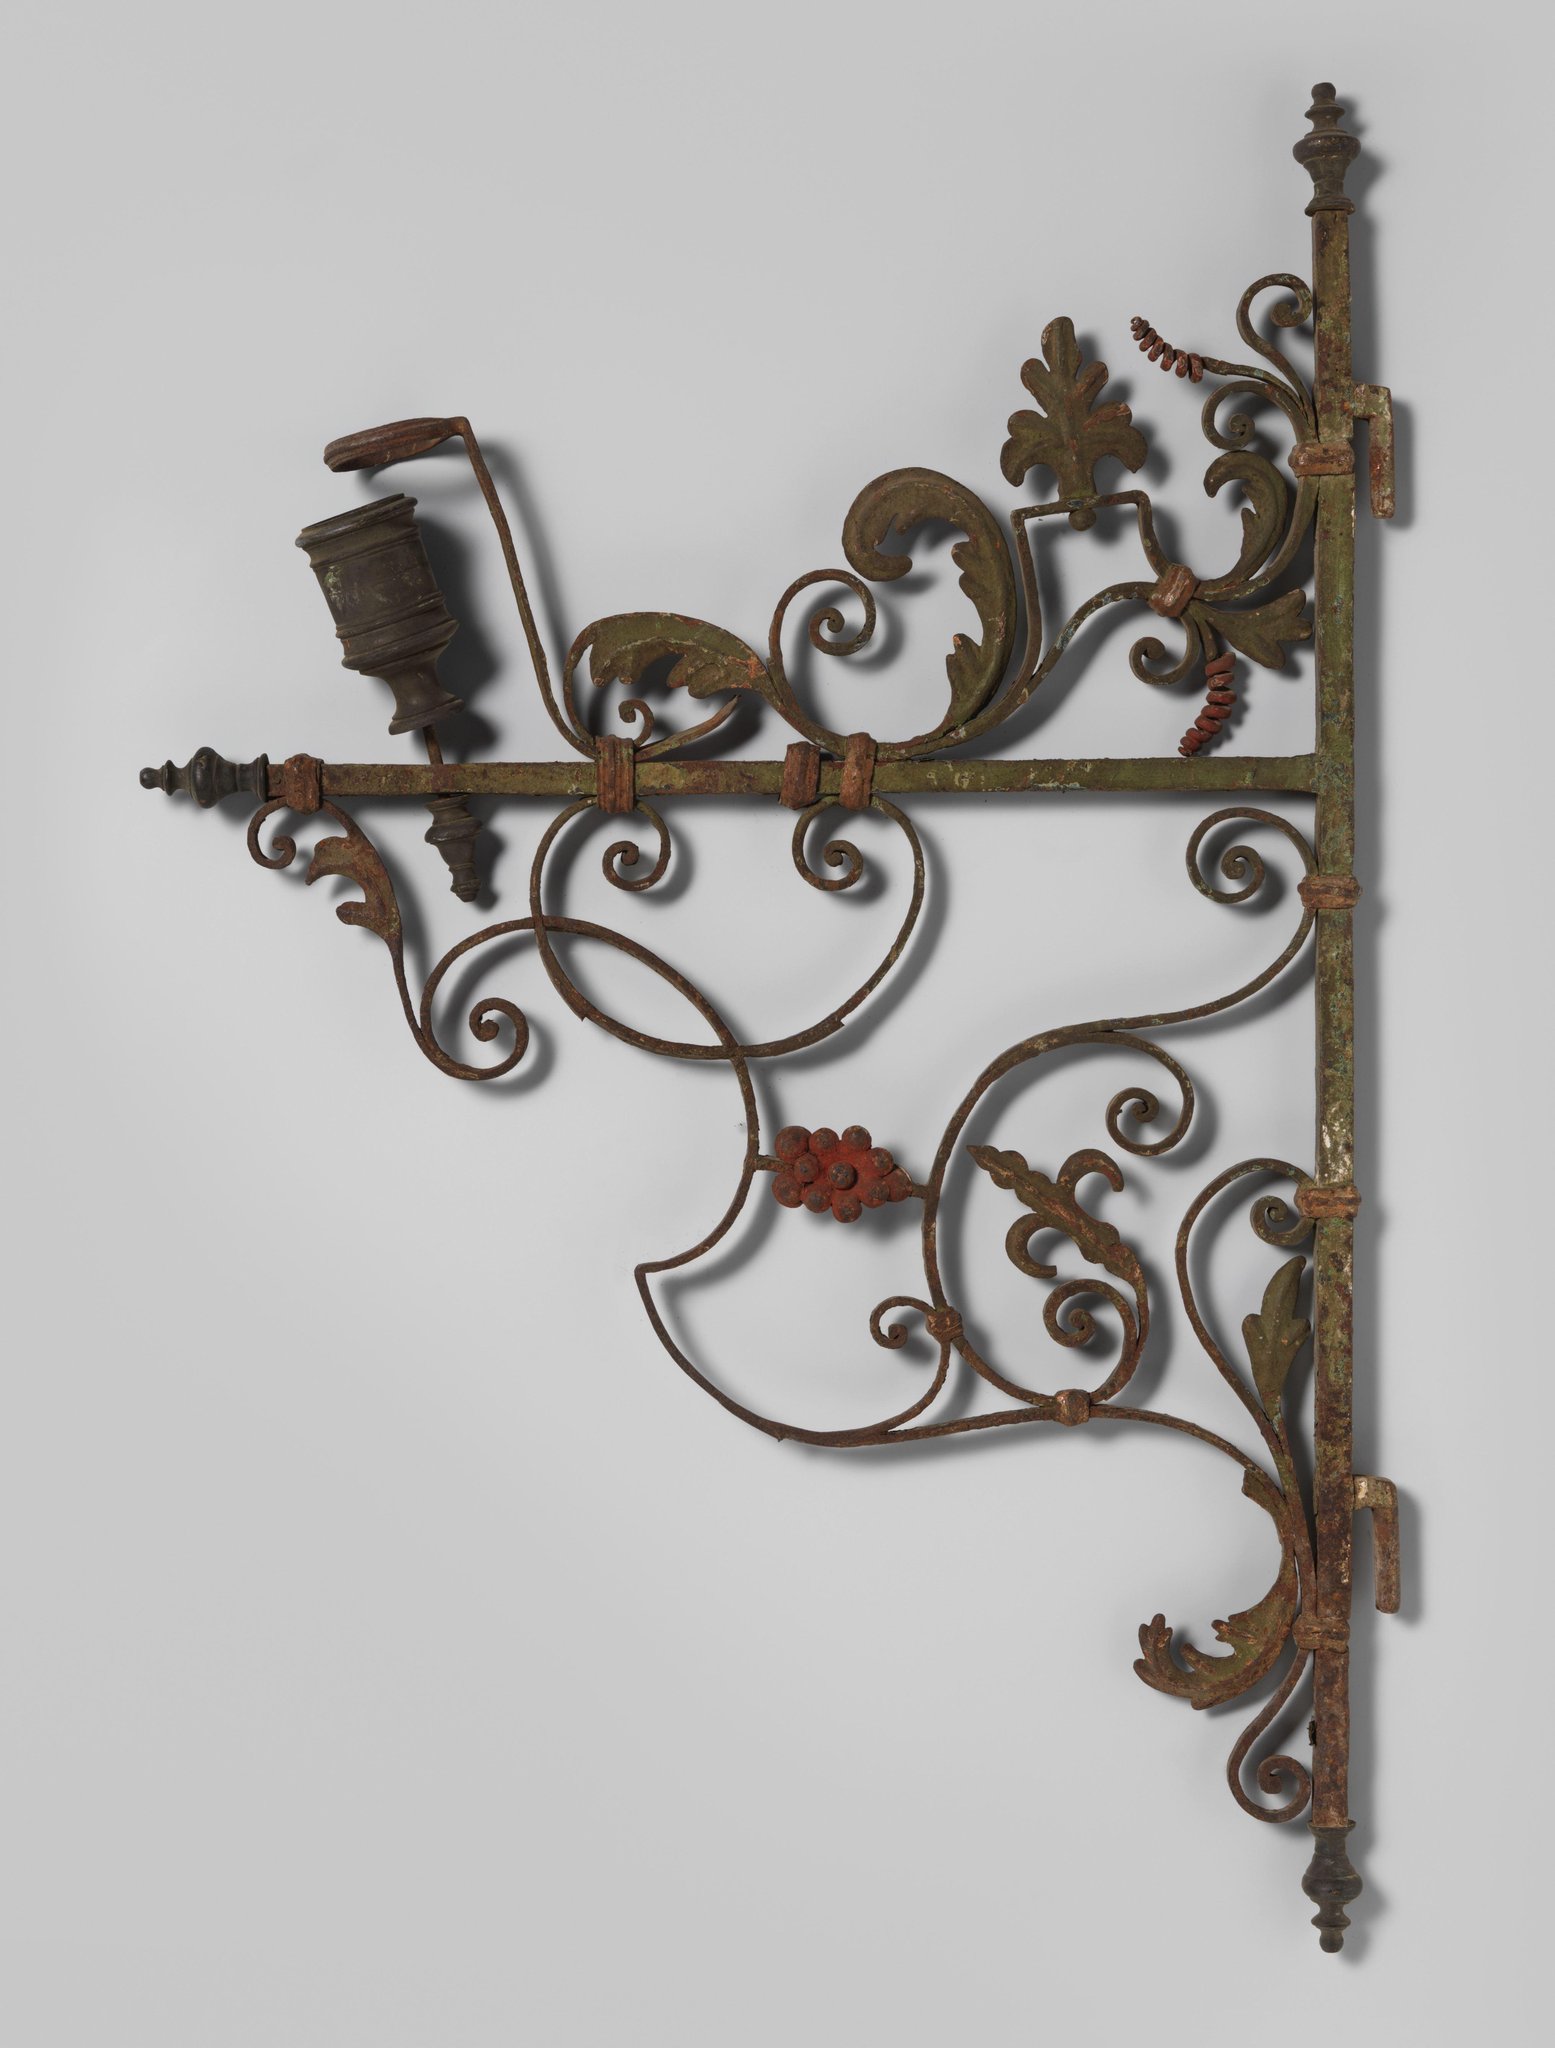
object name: uithangarm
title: Uithangarm, verz. Mannheimer.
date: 1700-1725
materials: bronze, iron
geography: italy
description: Een ijzeren uithangarm bestaande uit een verticale en een daarop loodrecht geplaatste horizontale vierzijdige stang waarvan de uiteinden zijn voorzien van geprofileerde knoppen. Op het einde van de horizontale stang een geprofileerde brons kaarsenhouder (?). De ongelijke hoekruimten die zijn otstaan, worden gevuld doorsierlijk gebogen S- en C-voluten waaruit hier en daar bladeren, vruchten en een palmet ontspruiten. Afkomstig uit de verzameling Dr. F. Mannheimer.